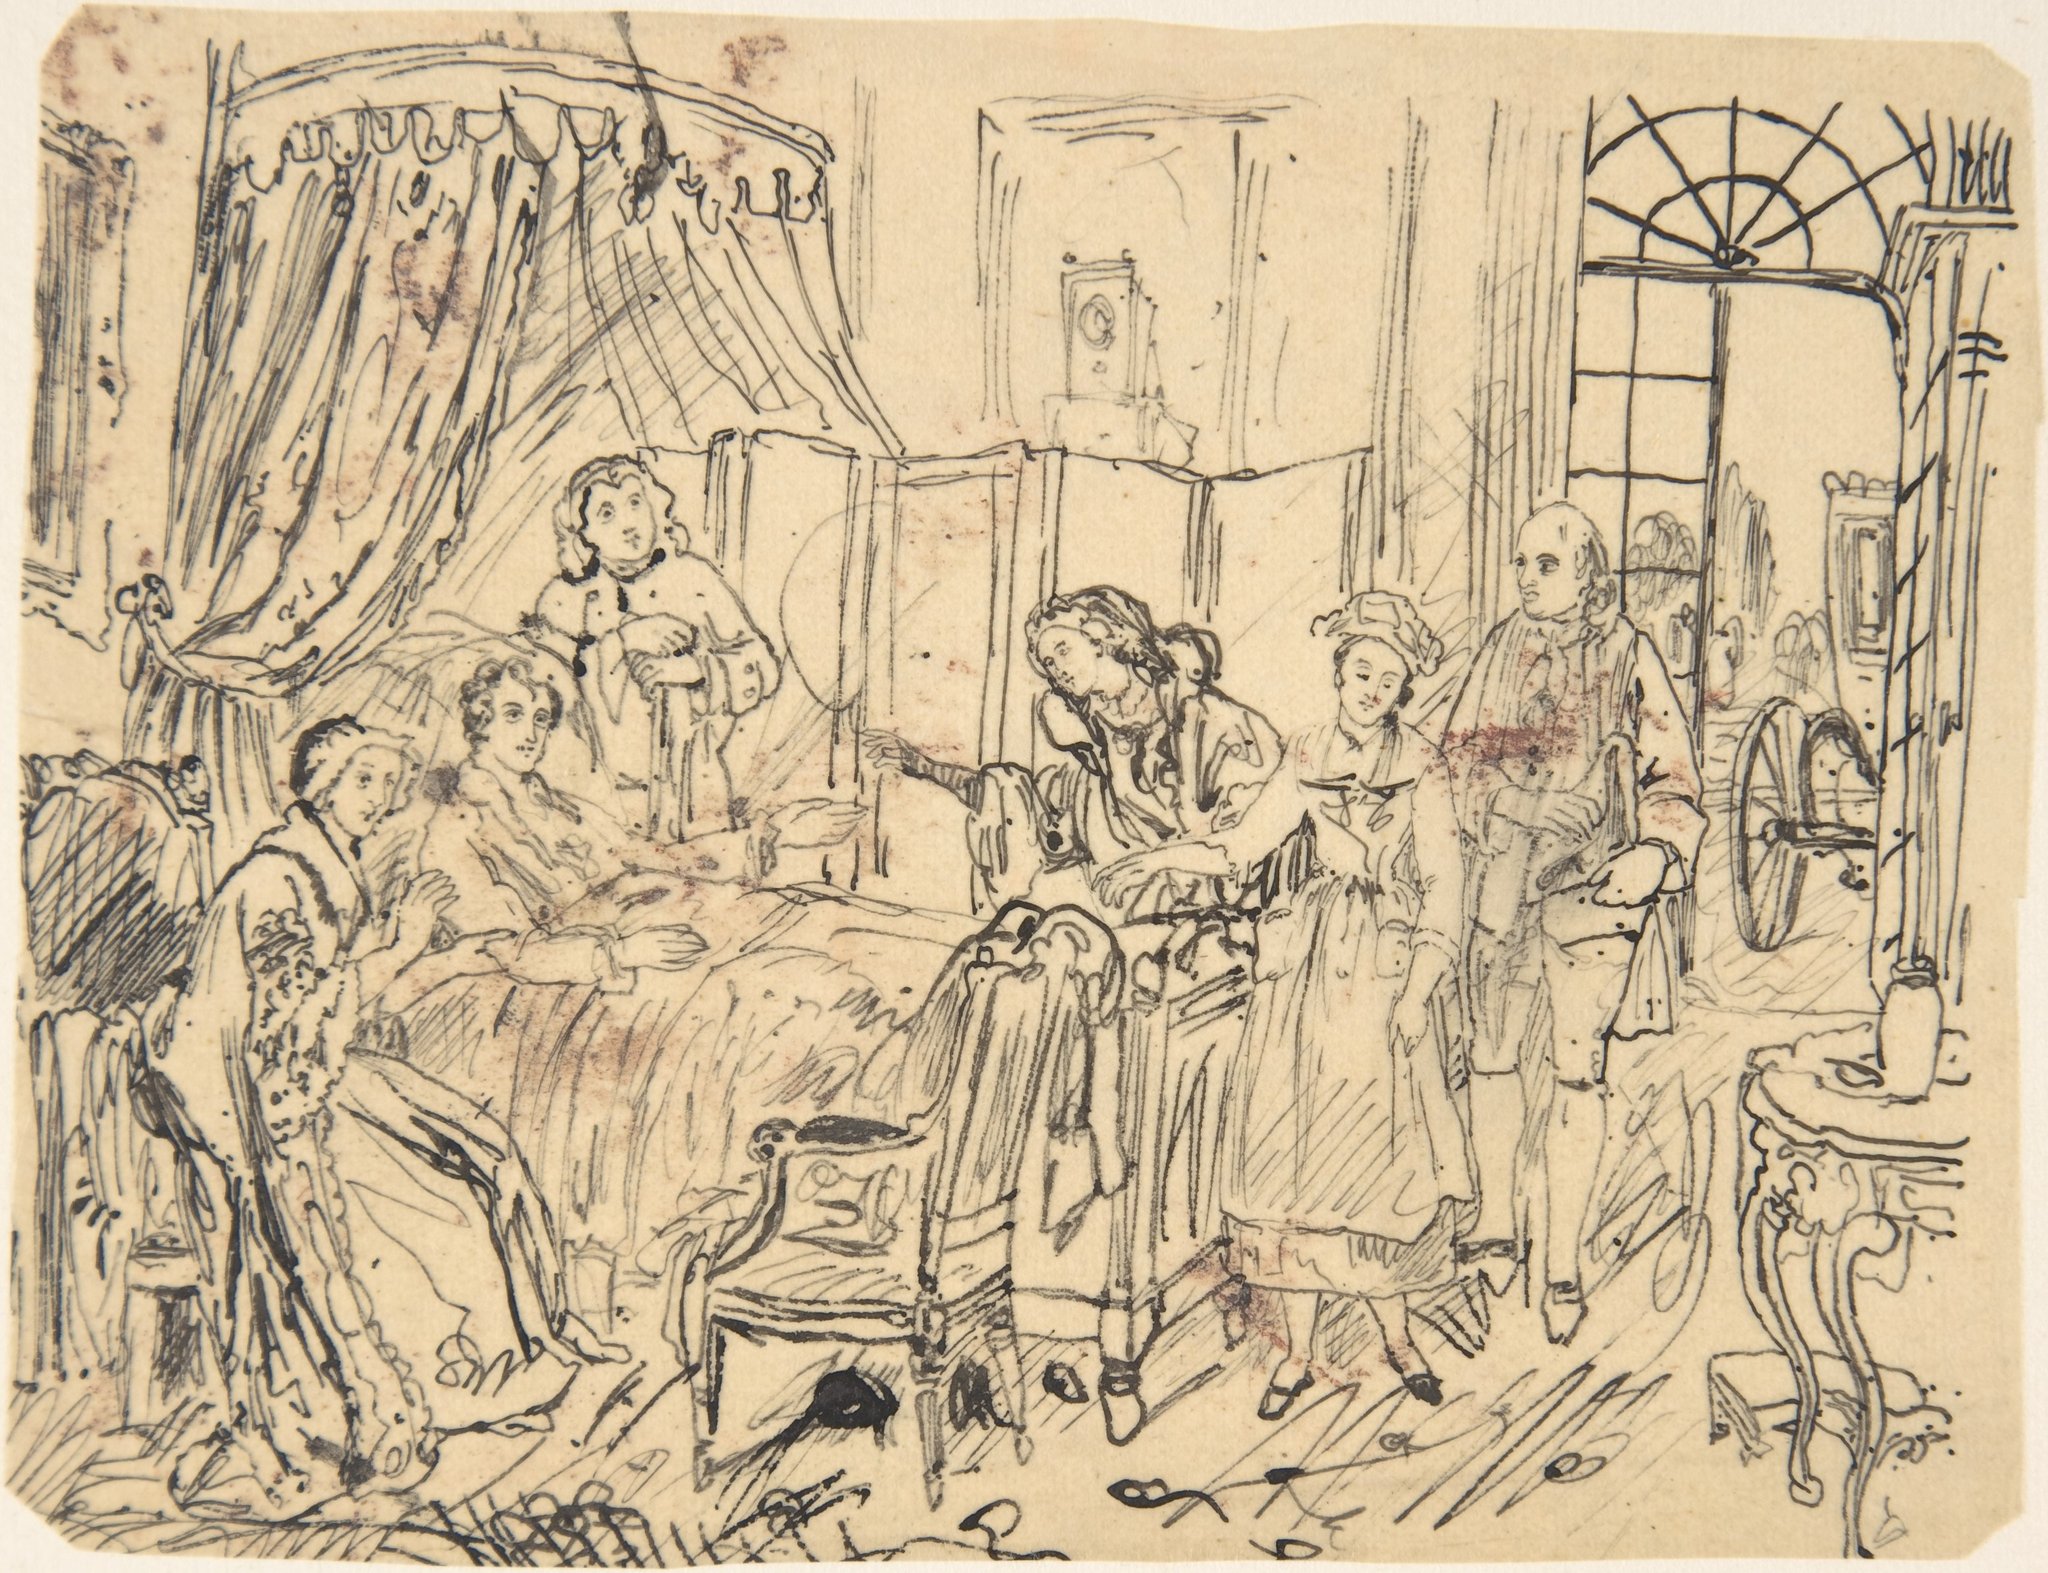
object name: drawing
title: The Convalescent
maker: rodolphe bresdin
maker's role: artist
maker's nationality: french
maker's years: 1822-1885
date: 1822-1885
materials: ink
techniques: pen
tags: bedrooms,illness,men,women